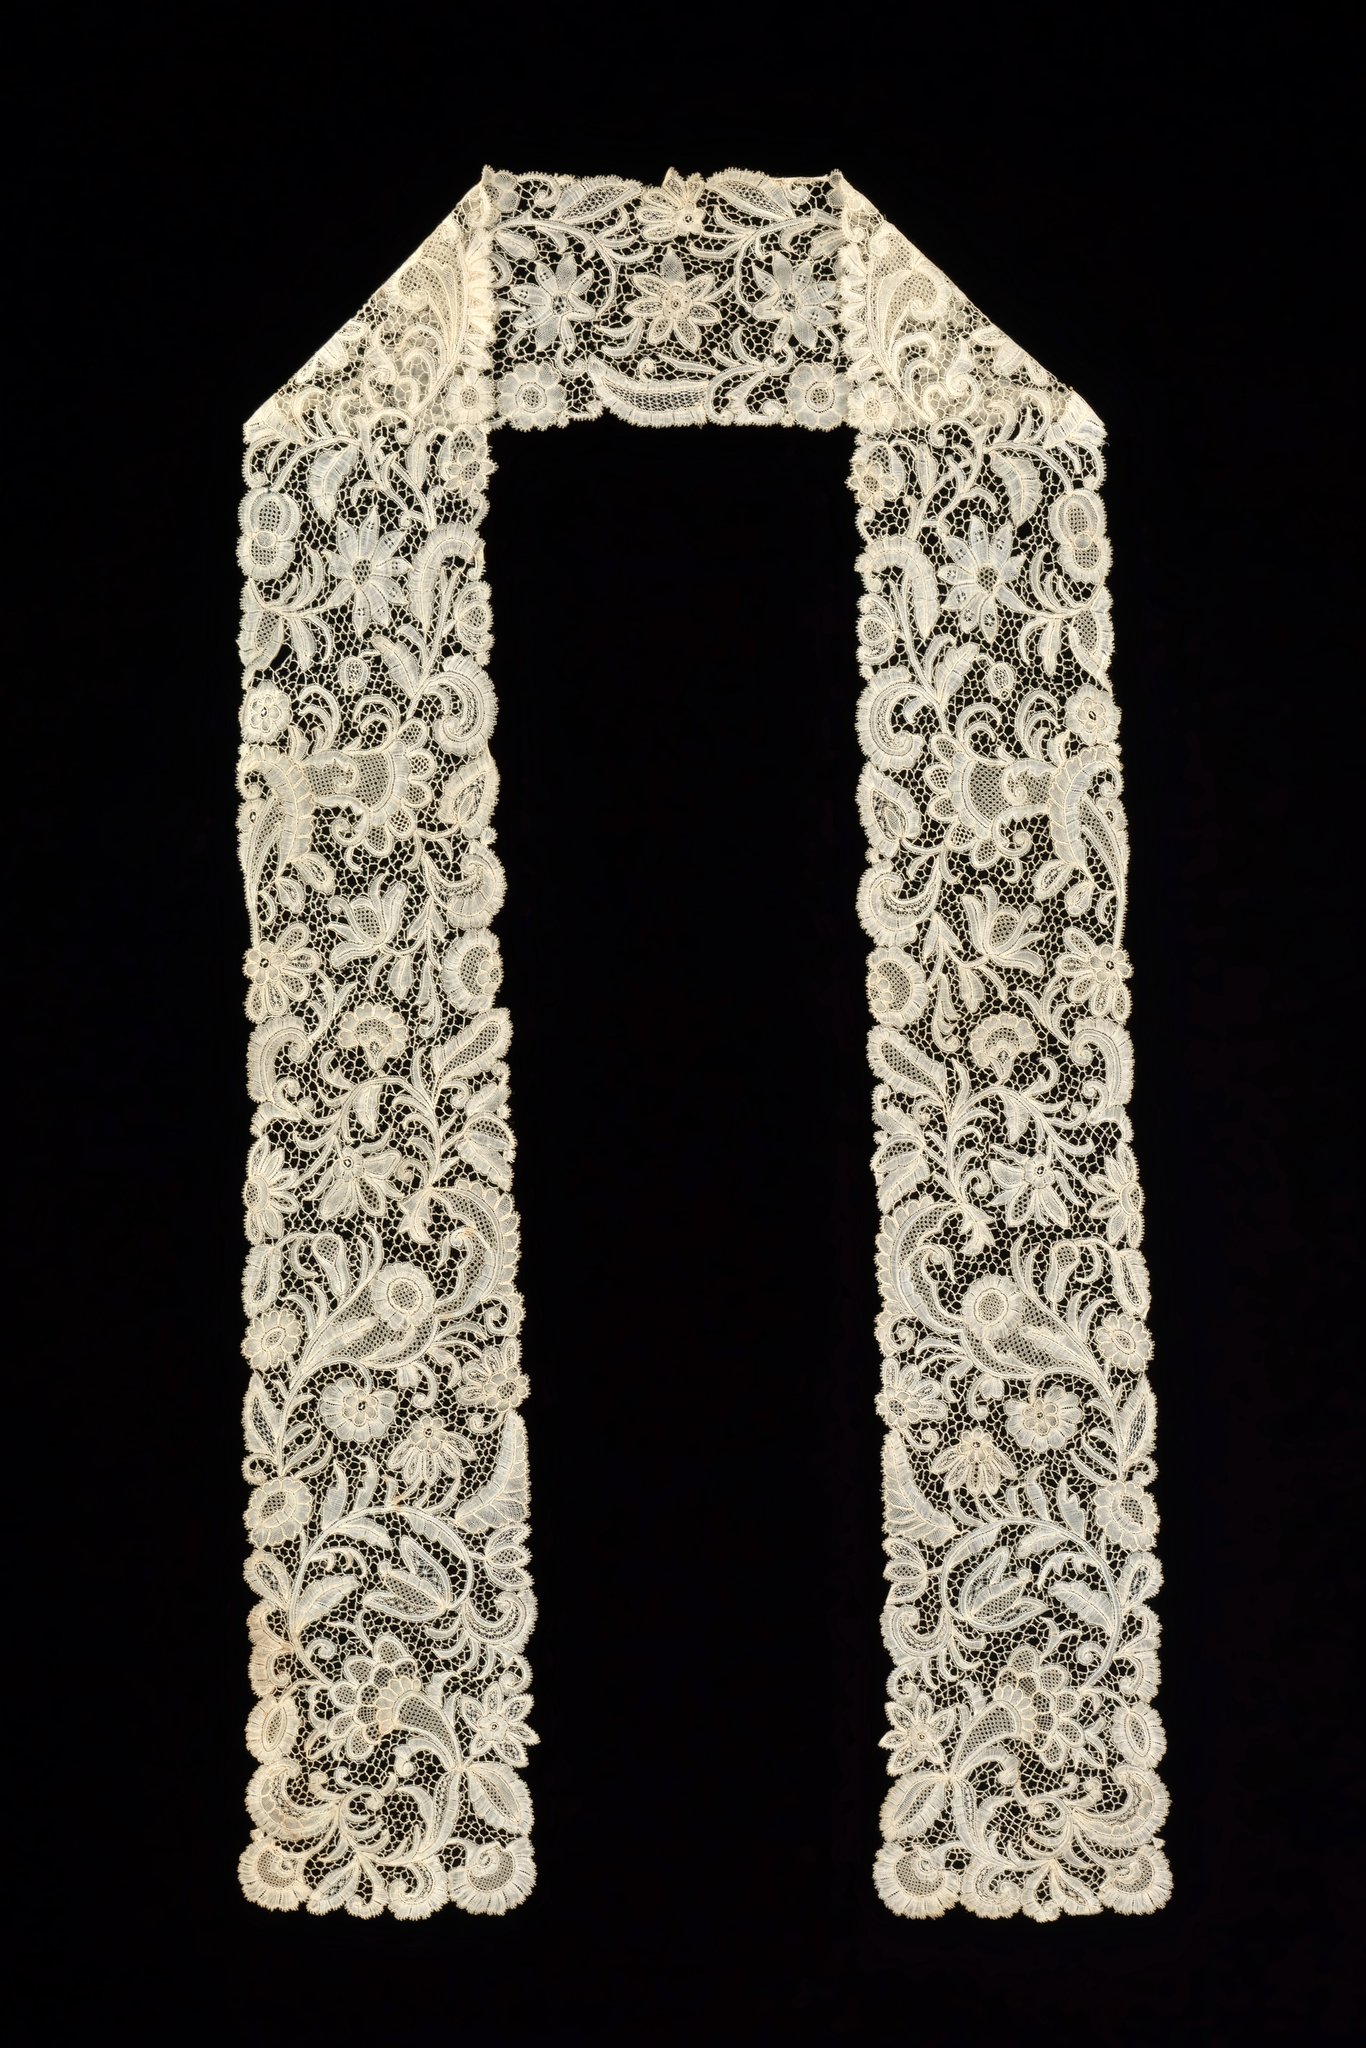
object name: lappet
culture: flemish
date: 1876-1900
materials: linen